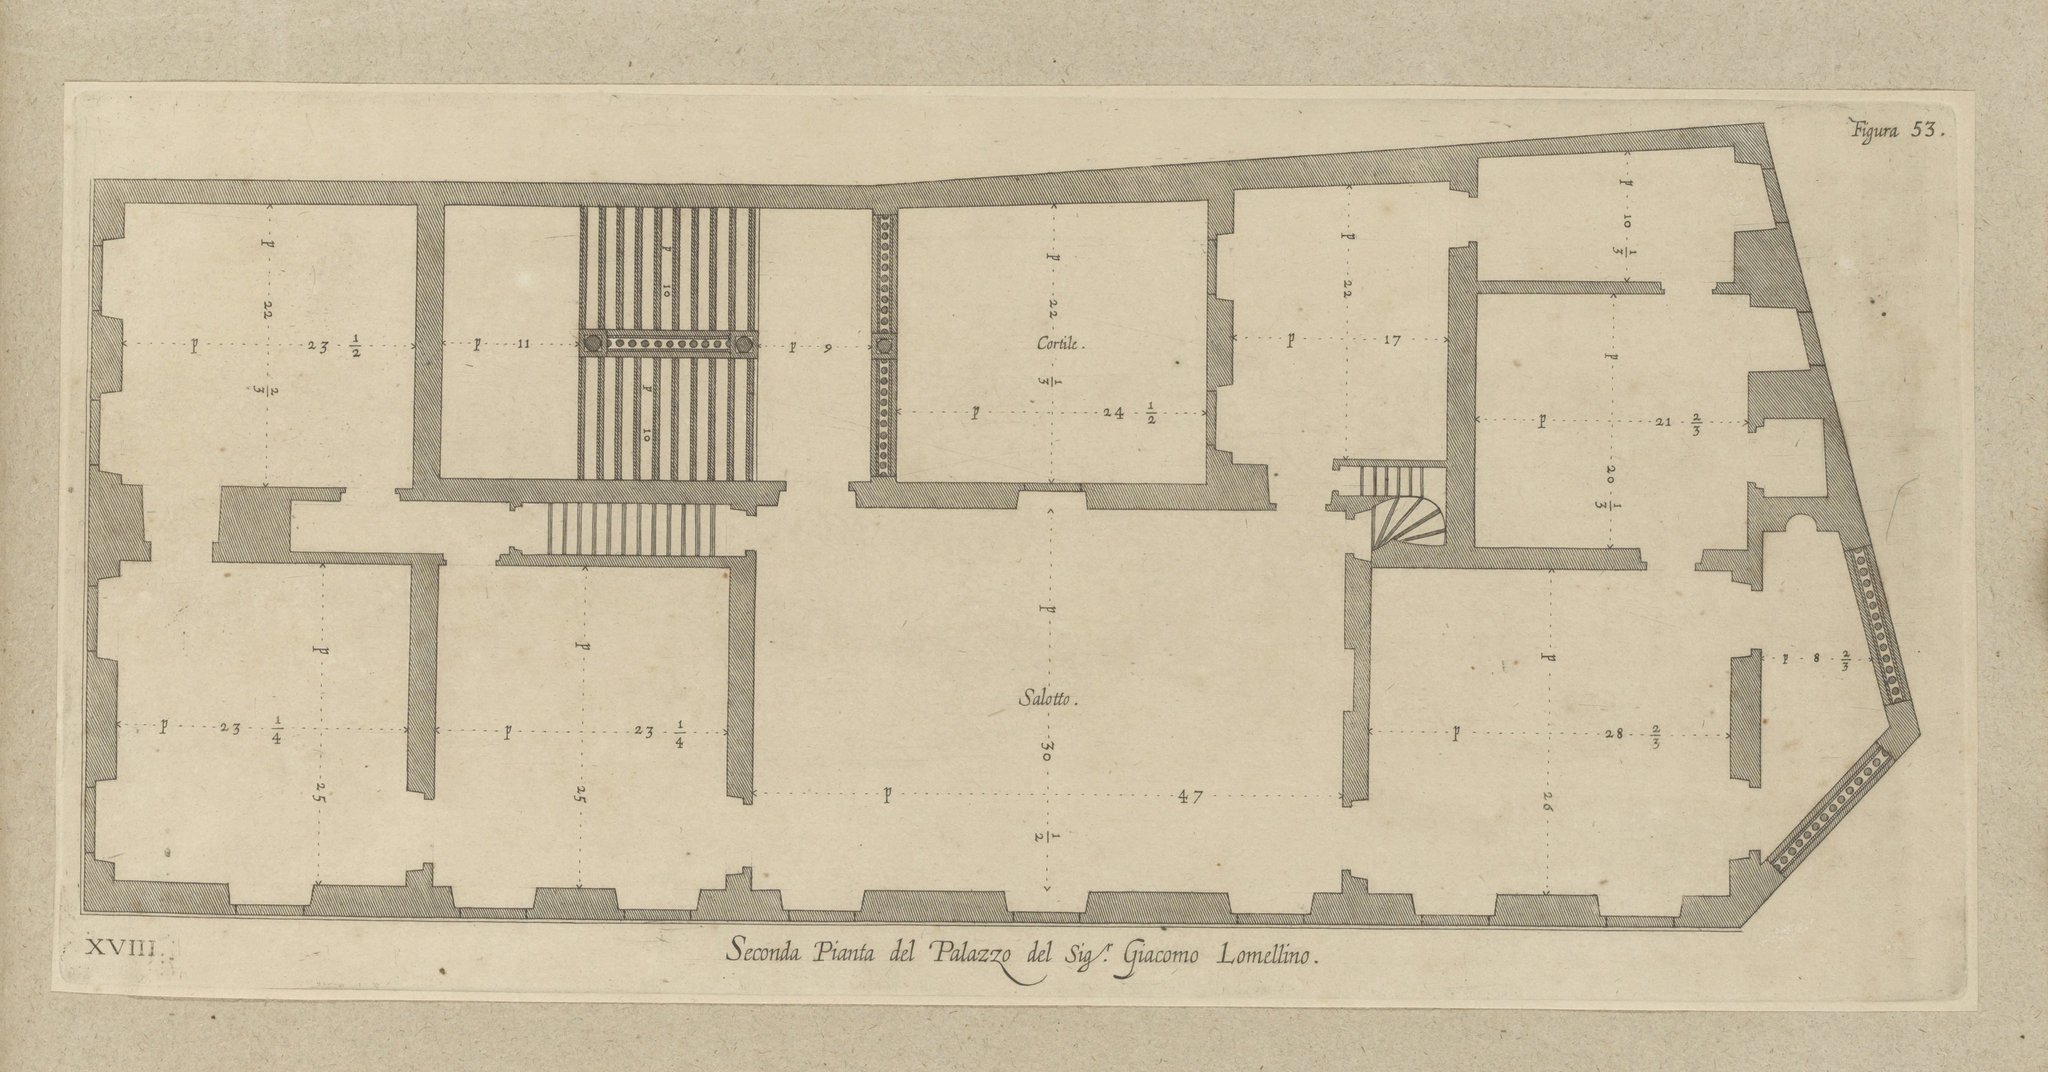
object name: album leaf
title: Seconda pianta del Palazzo del sigr. Giacomo Lomellino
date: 1622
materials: paper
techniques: engraving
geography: antwerp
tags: hôtel, i.e. small palace in city - aa - civic architecture: inside, plan ~ architecture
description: Deze prent maakt deel uit van een album.